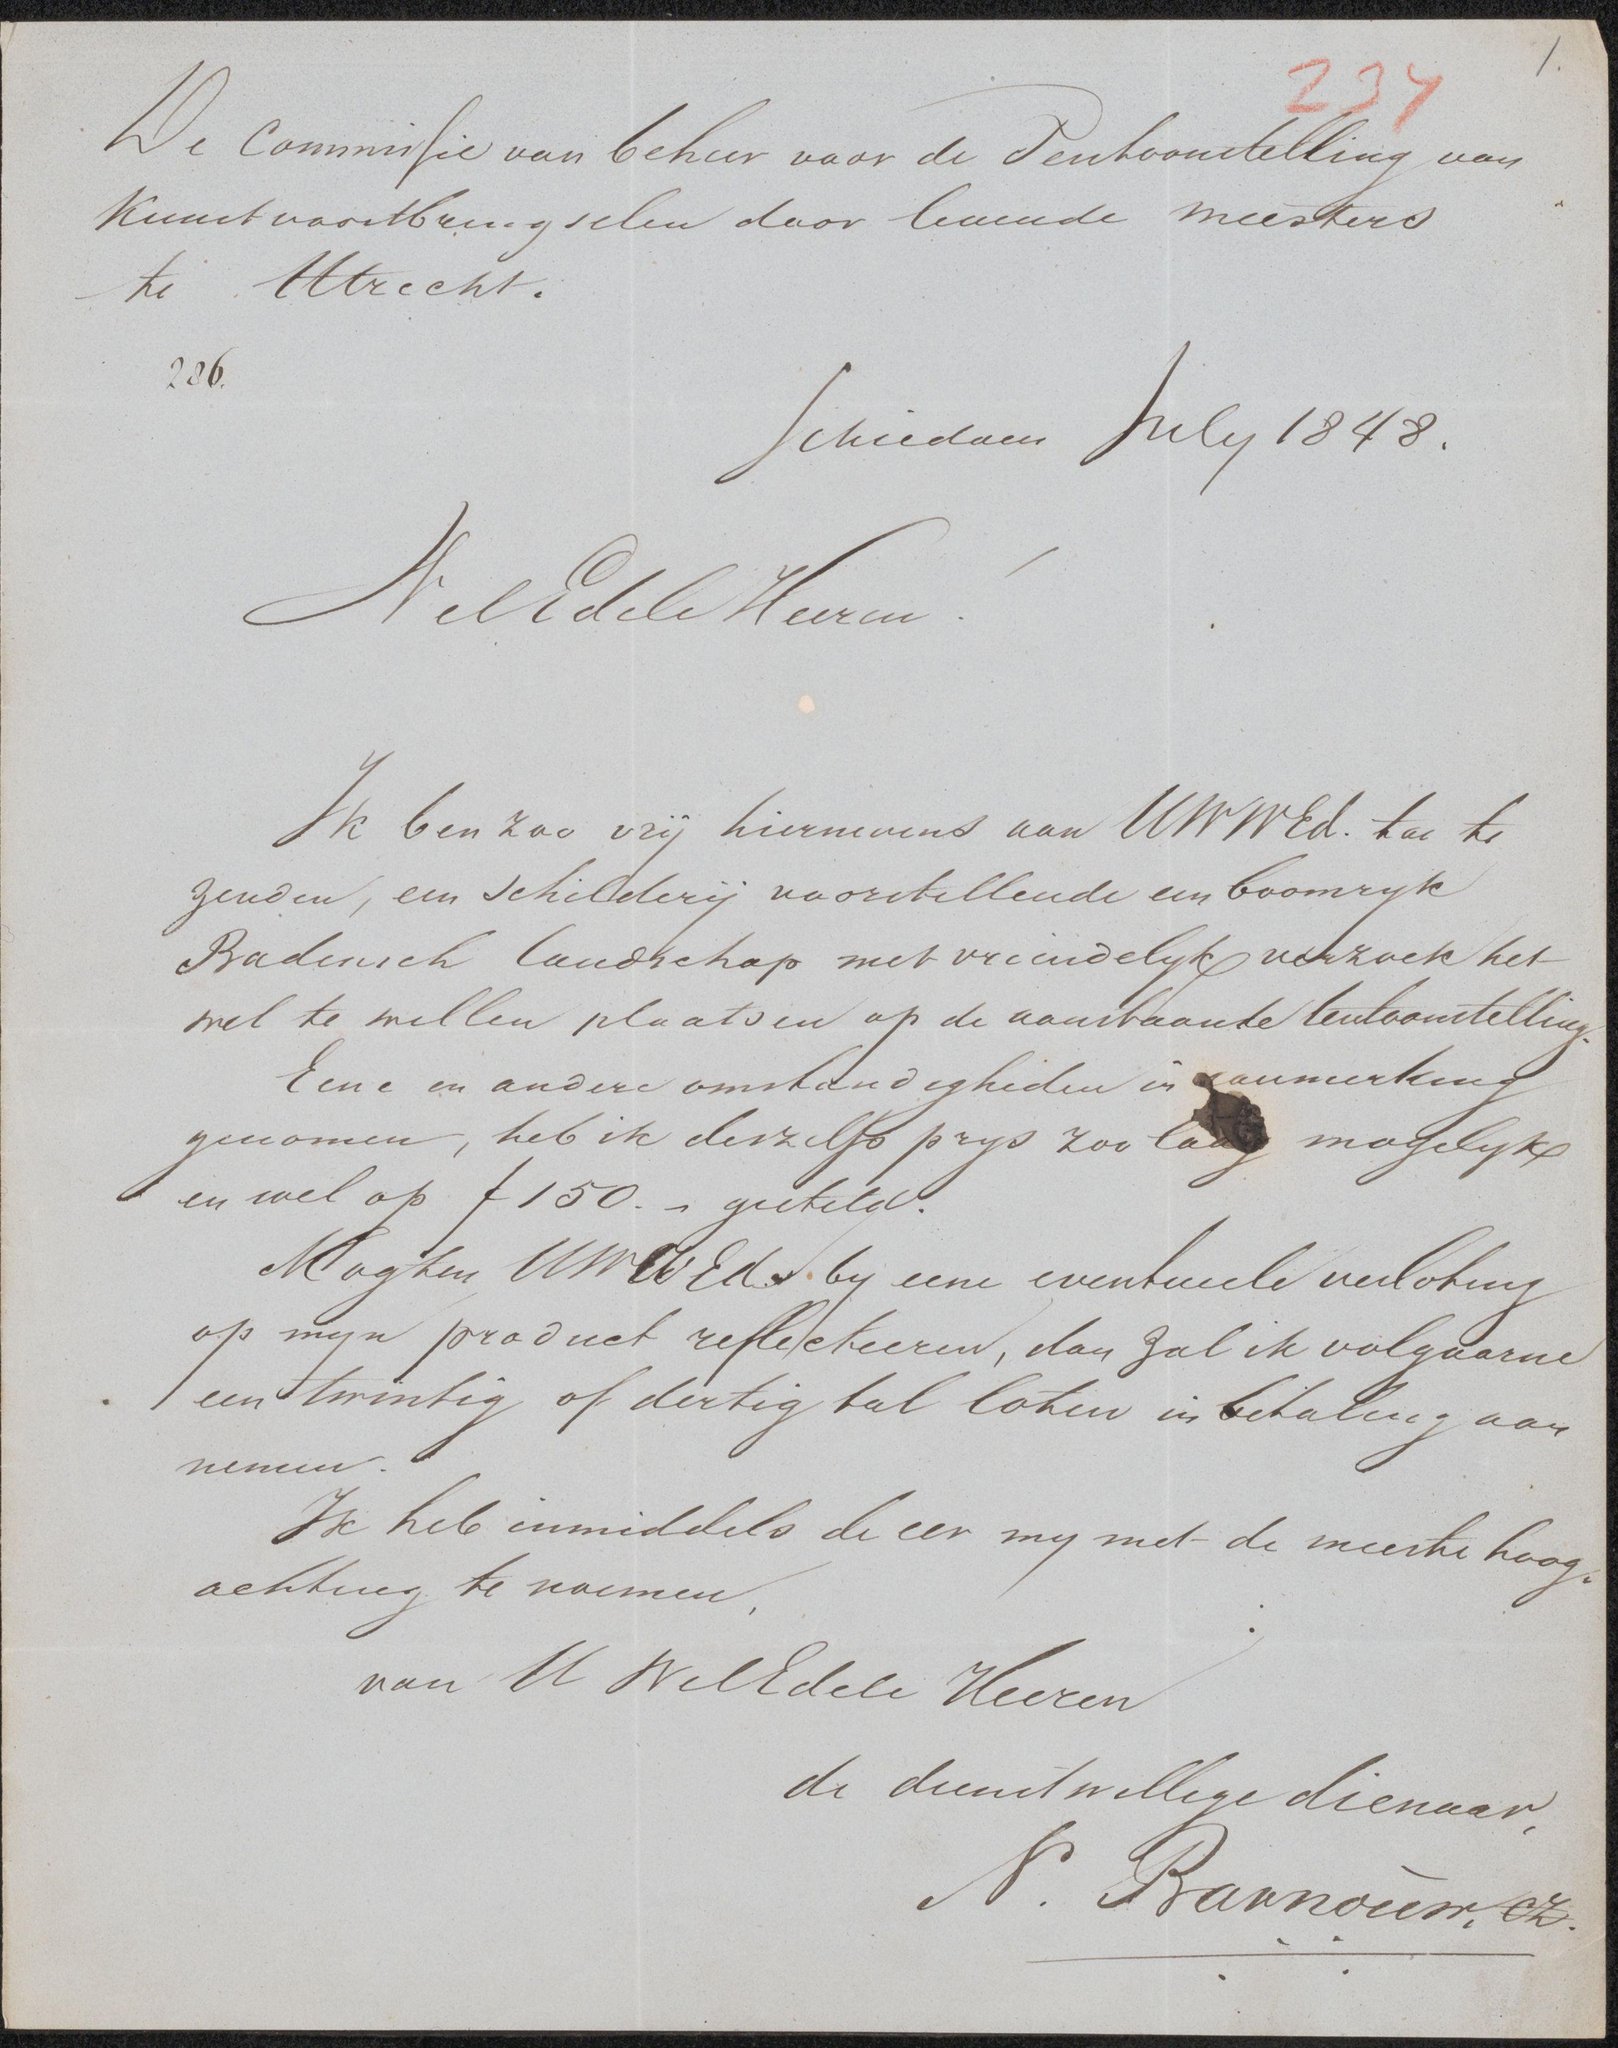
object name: letter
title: Brief aan de commissie van de Tentoonstelling van Levende Meesters in Utrecht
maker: nicolaas barnouw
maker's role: painter, print maker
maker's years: 1809-1873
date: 1807-1848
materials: ink, paper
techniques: pen, writing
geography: schiedam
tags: painting (including book-illumination, miniature-painting), exhibition ~ art, money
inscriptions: collector's mark: Lugt 2233